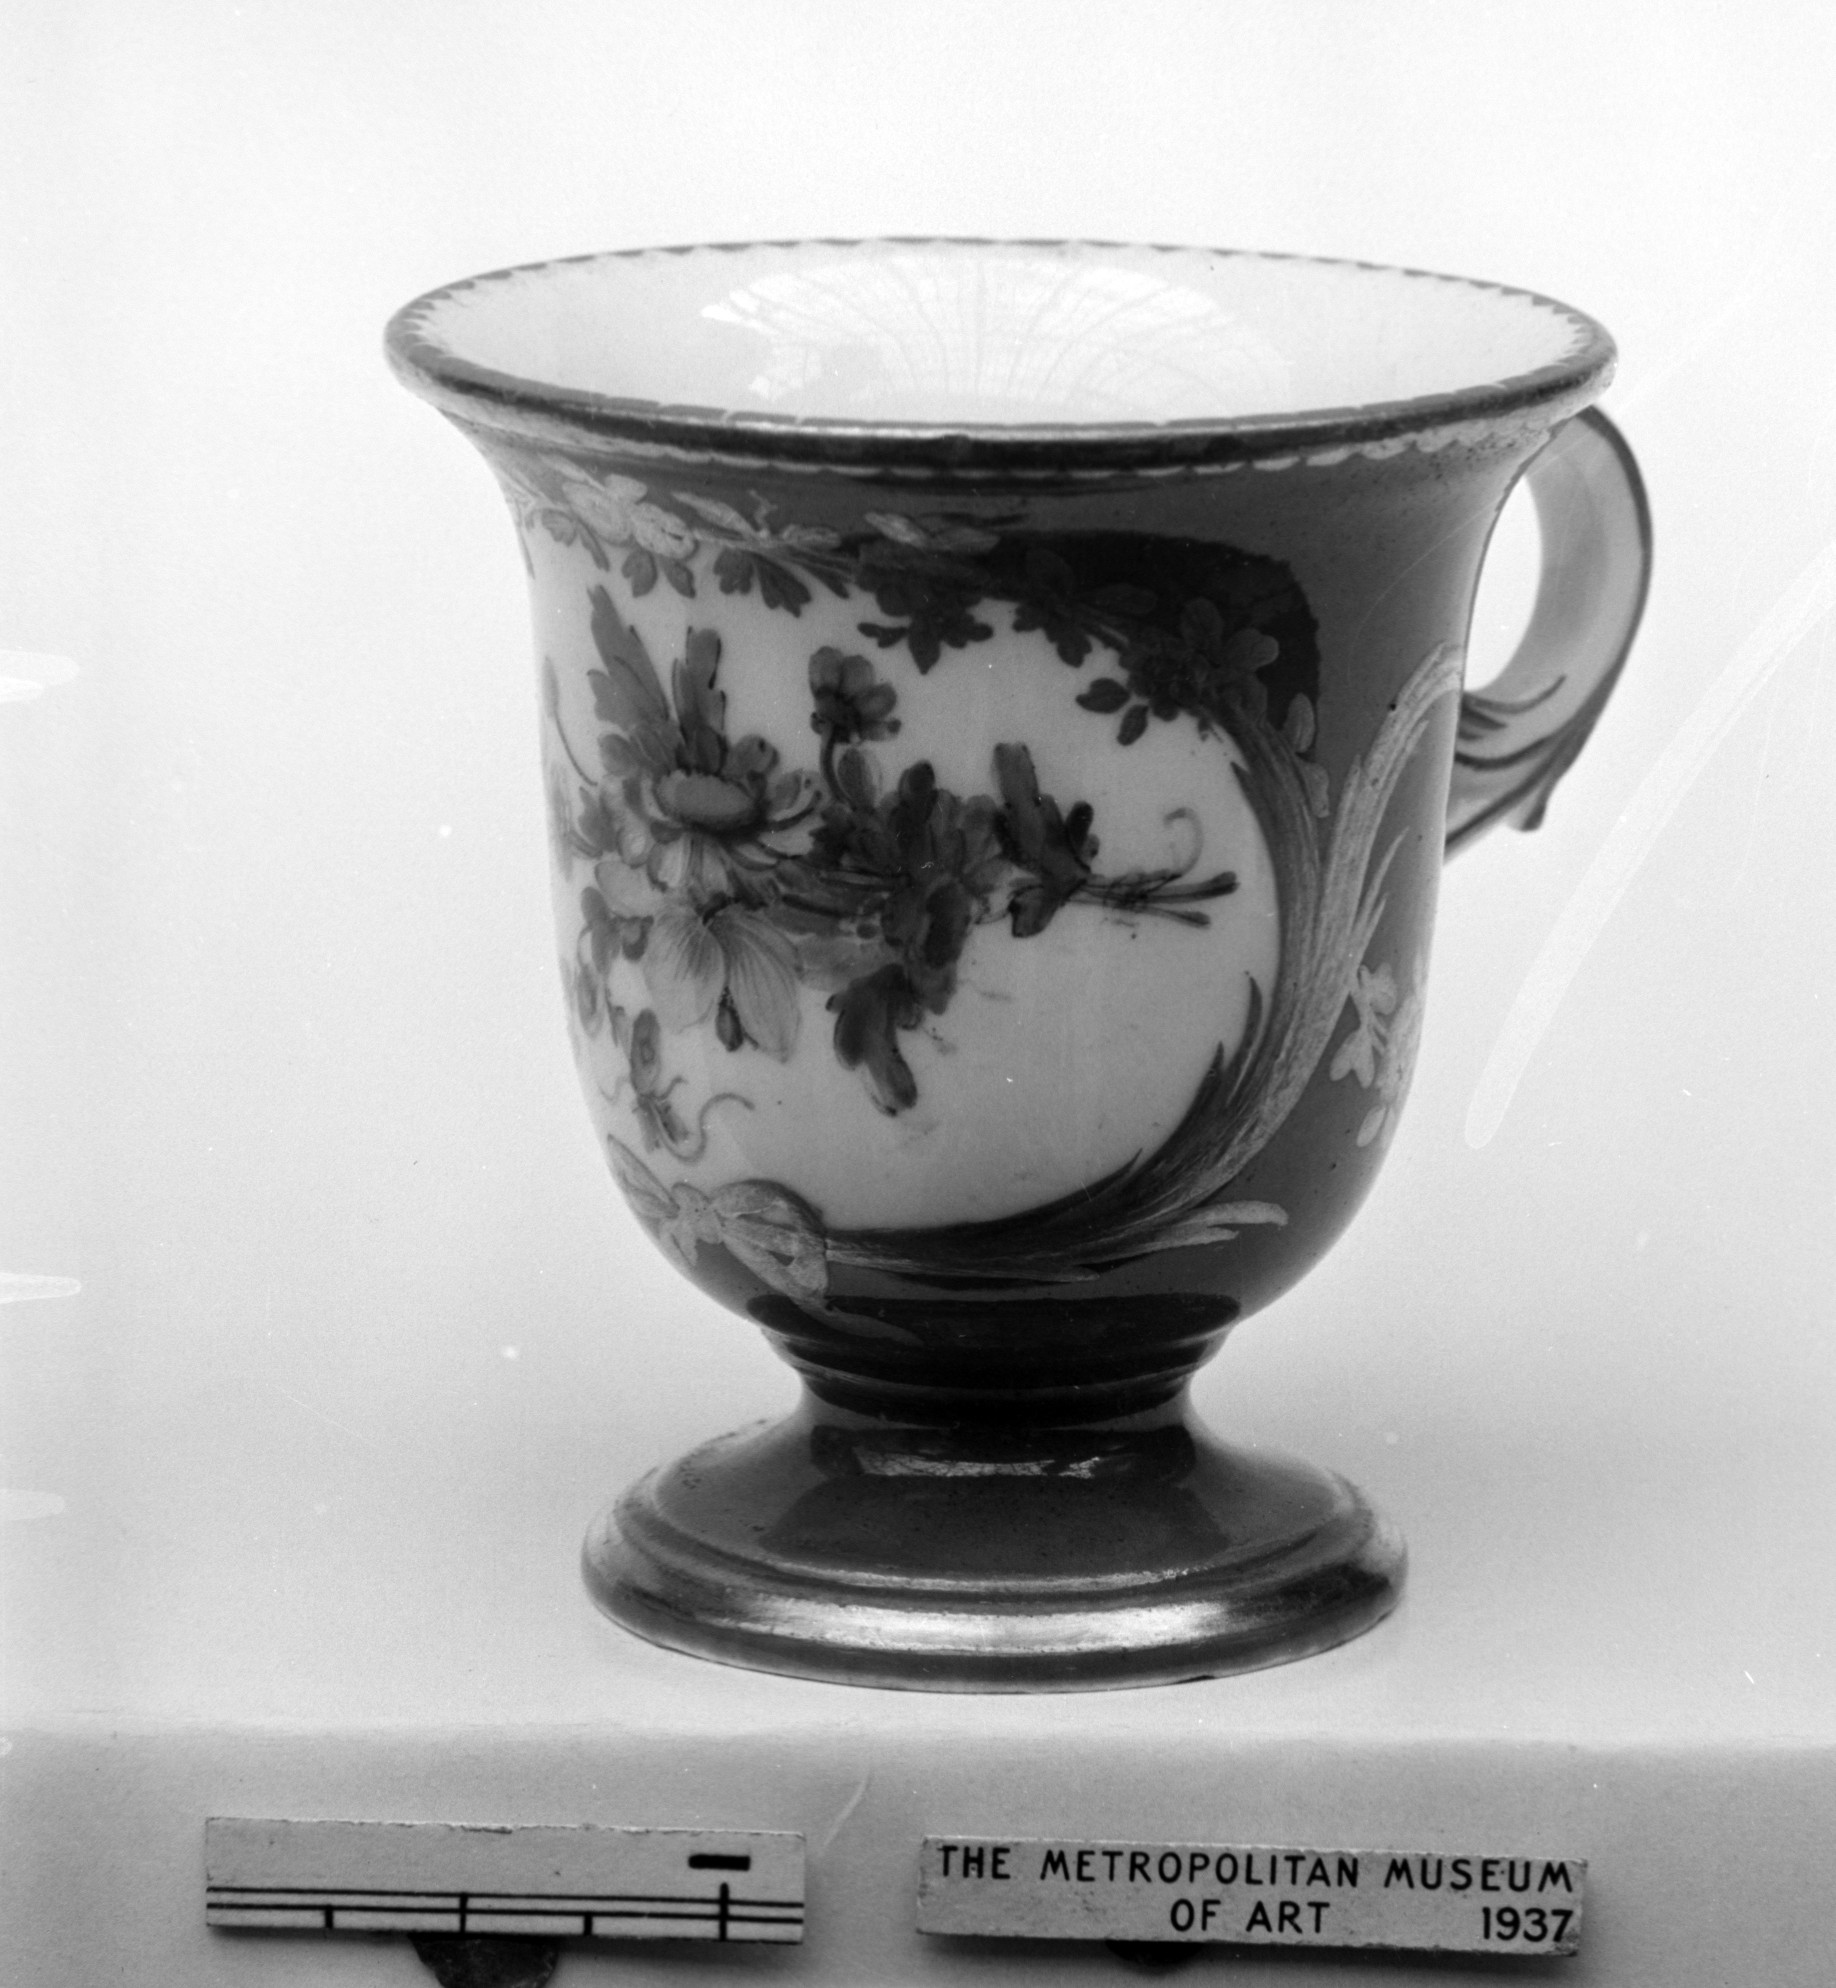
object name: ice cream cup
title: Ice cream cup (Tasse à glace) (part of a service)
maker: sèvres manufactory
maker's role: manufactory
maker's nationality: french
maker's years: 1740-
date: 1780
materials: soft paste porcelain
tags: flowers